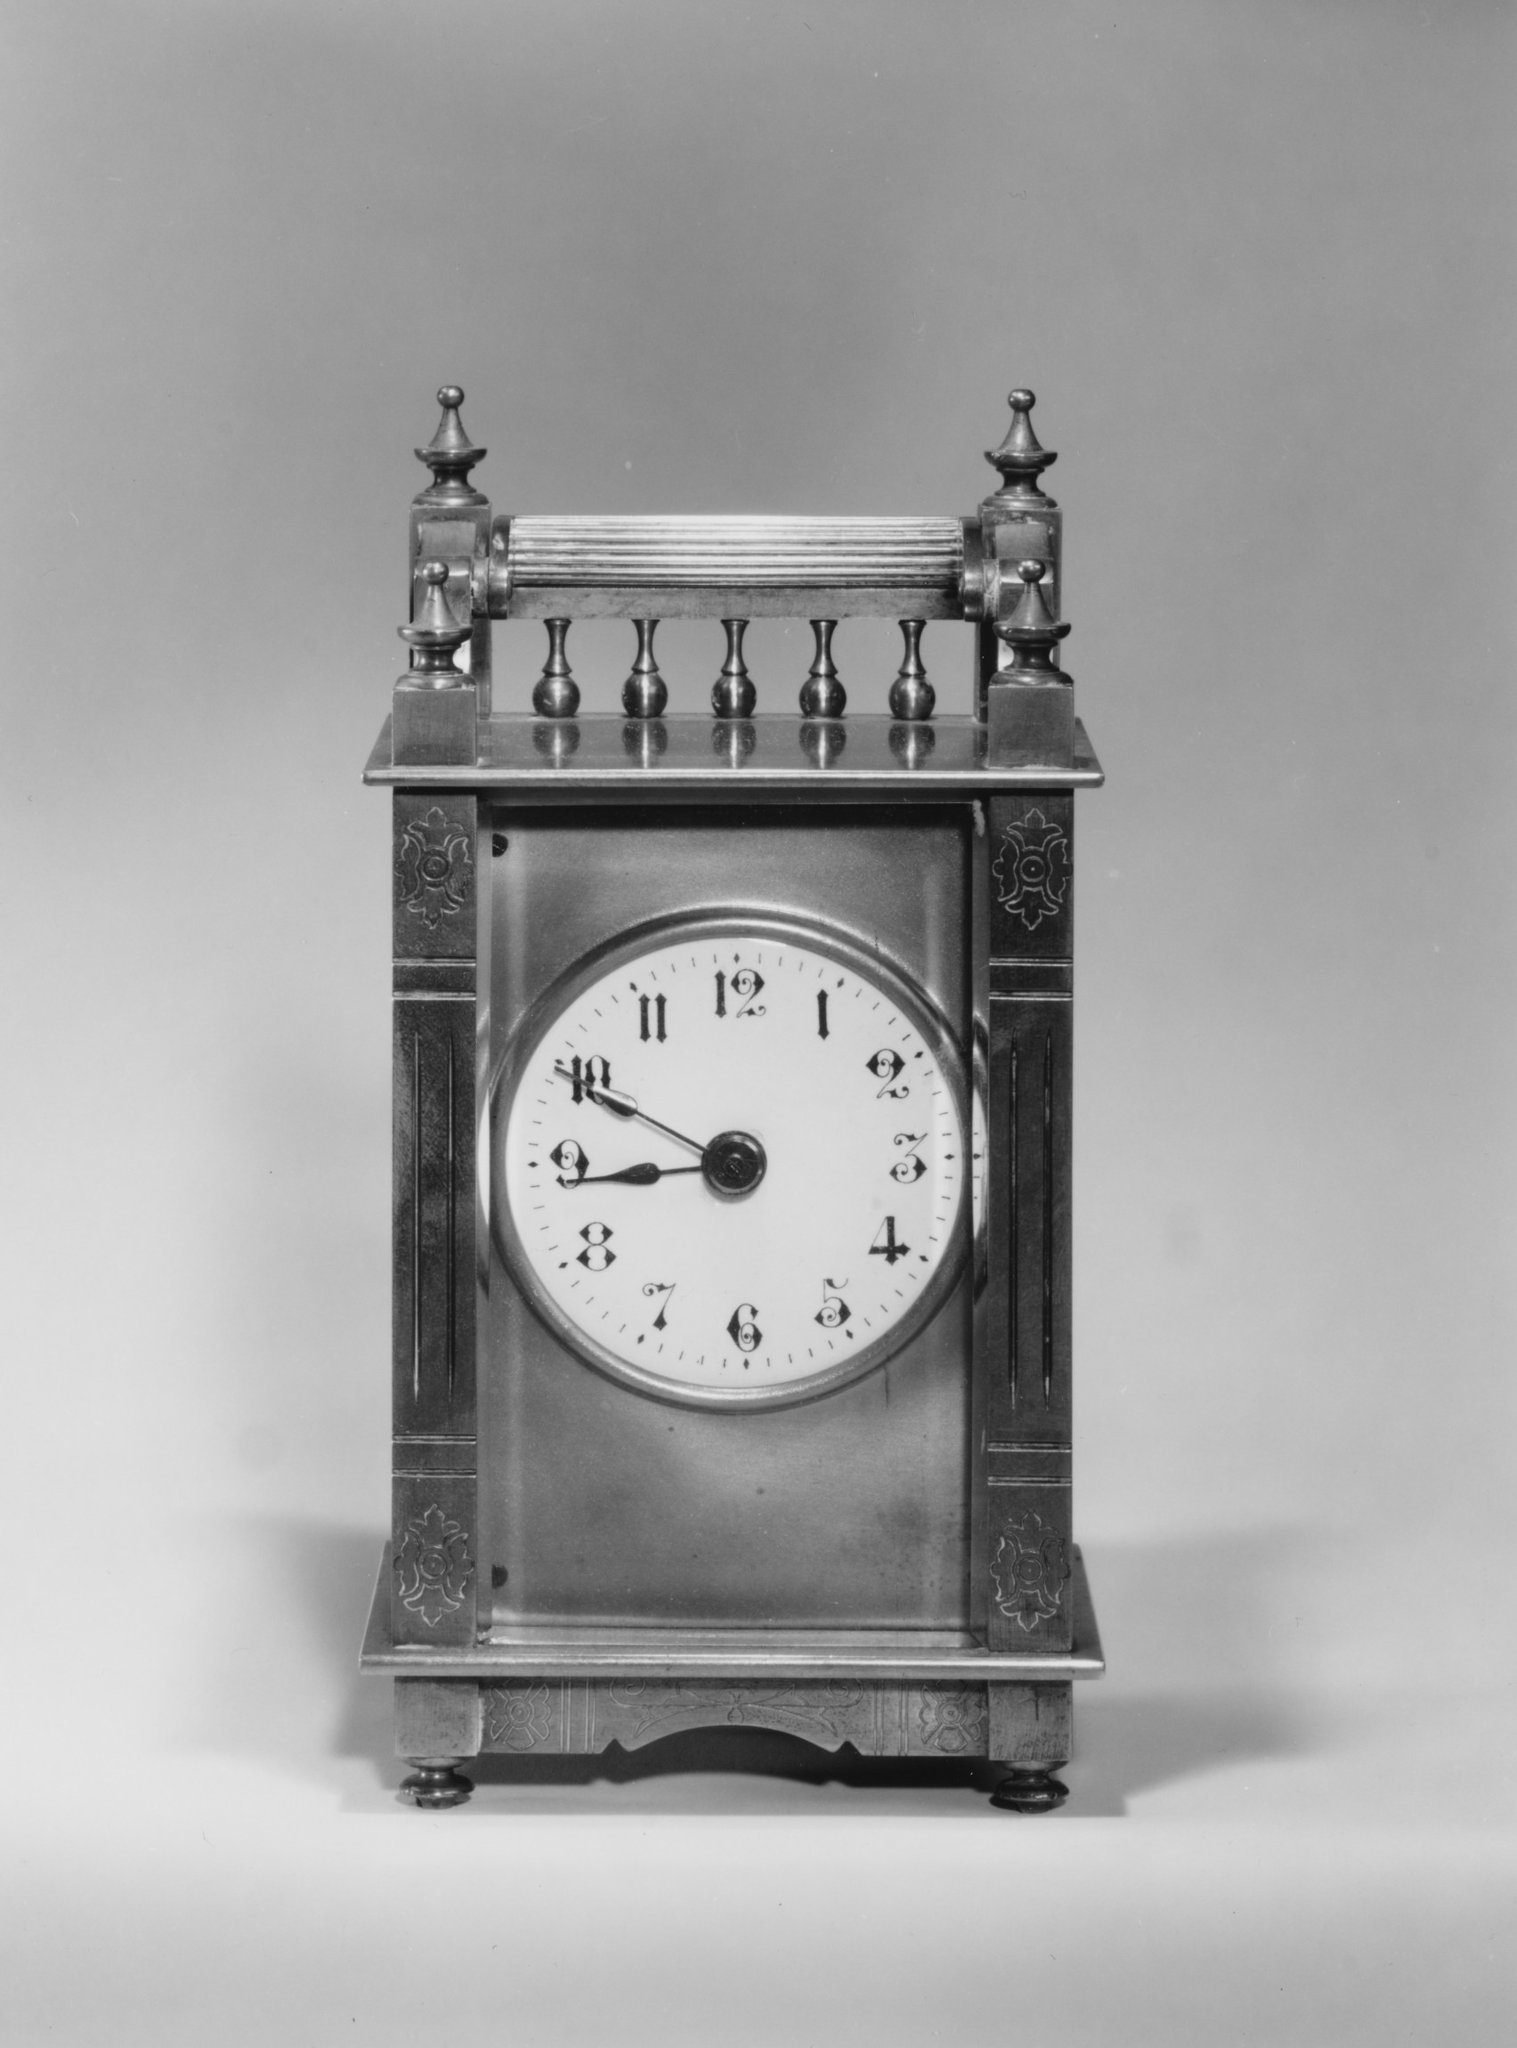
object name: carriage clock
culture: american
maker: boston clock company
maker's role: maker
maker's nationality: american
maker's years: 1888-1897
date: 1890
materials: brass, enamel, glass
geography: united states